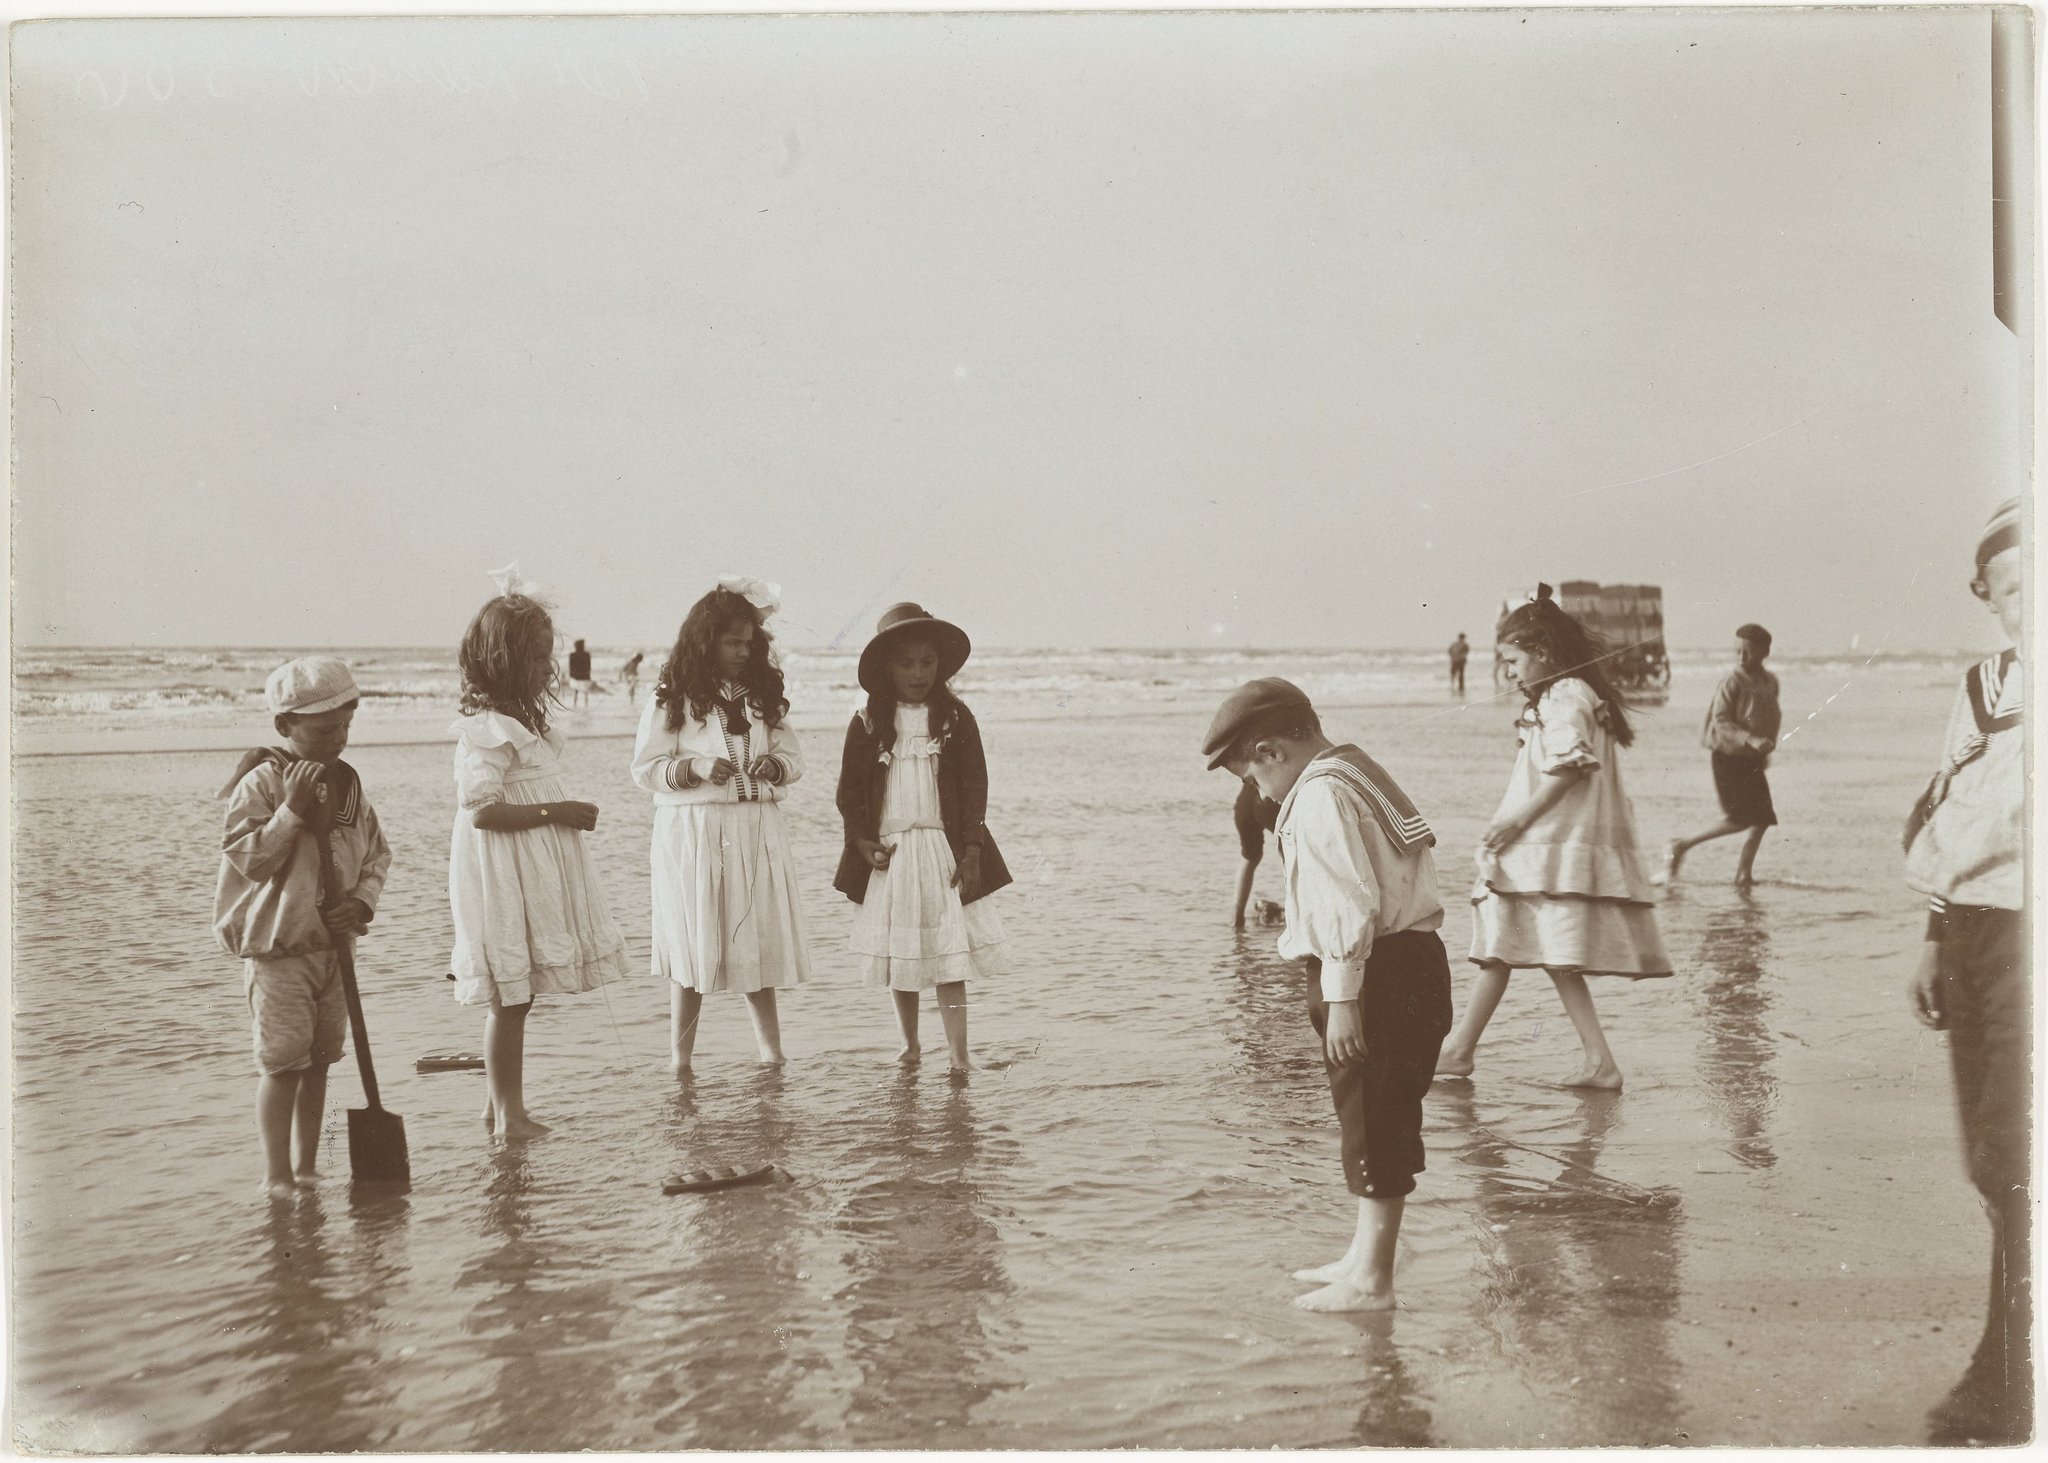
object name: photograph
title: Pootje baden aan het strand in Zandvoort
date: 1900-1905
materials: photographic support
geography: zandvoort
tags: beach (as place of recreation)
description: Jongens en meisjes zijn, geheel aangekleed, aan het pootje baden in zee, een jongen heeft een schep een ander laat een bootje varen.